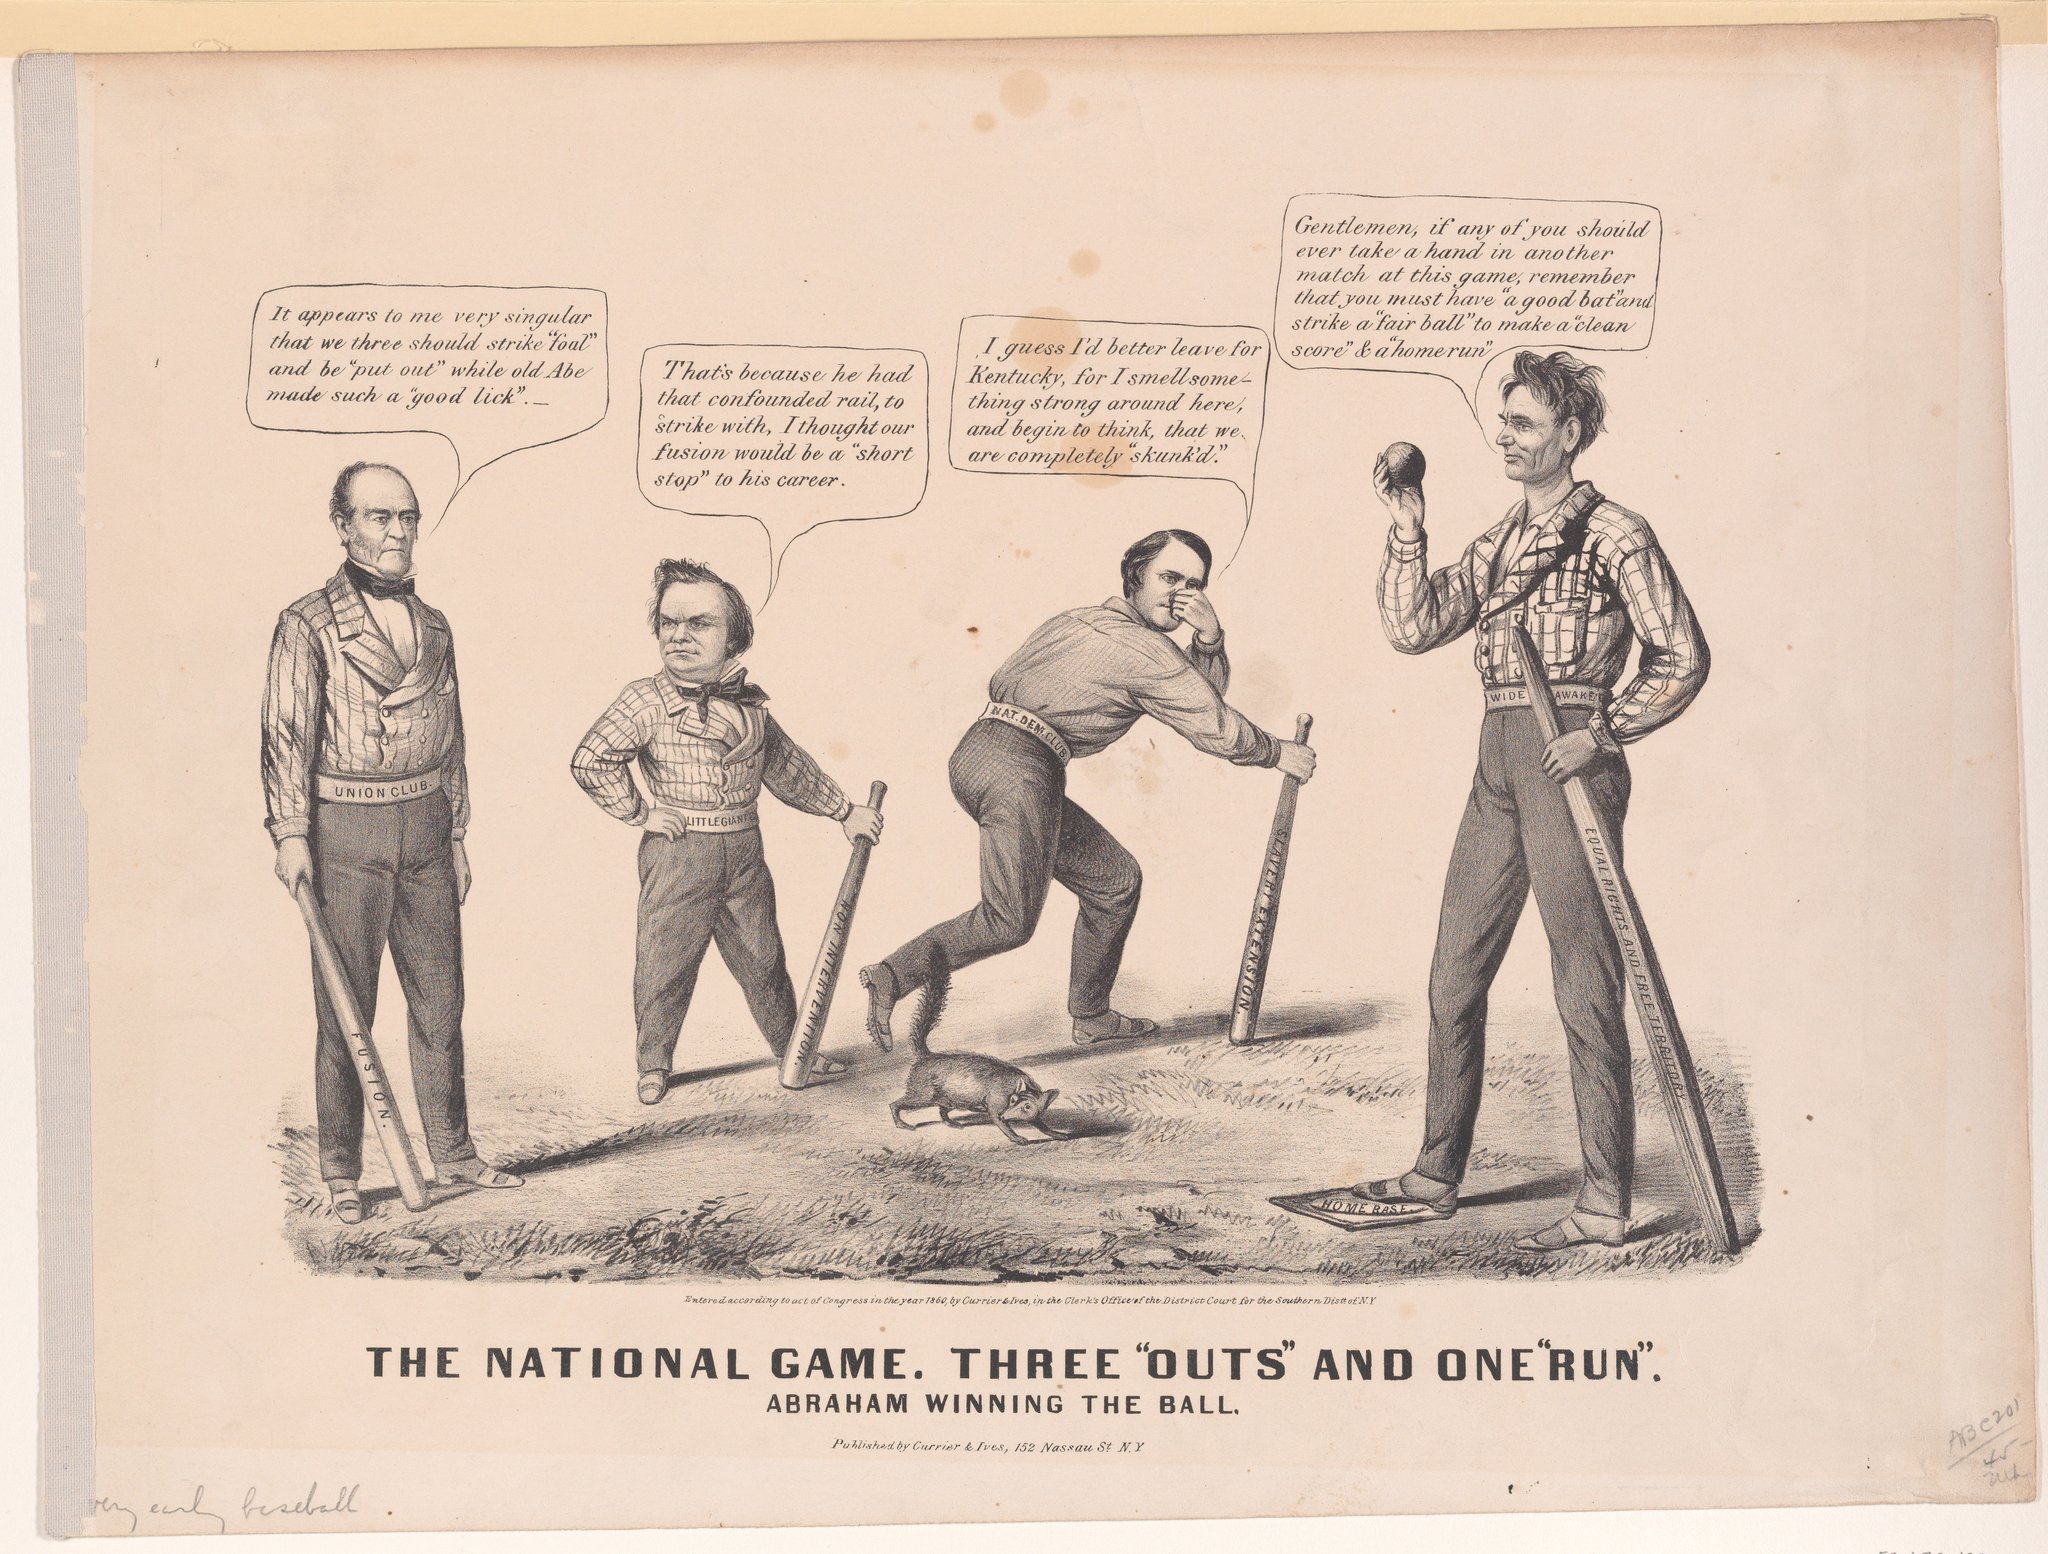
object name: print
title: The National Game. Three "Outs" and One "Run" – Abraham Winning the Ball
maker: louis maurer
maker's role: artist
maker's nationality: american, born germany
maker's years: 1832-1932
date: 1860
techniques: lithograph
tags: satire,abraham lincoln,politics